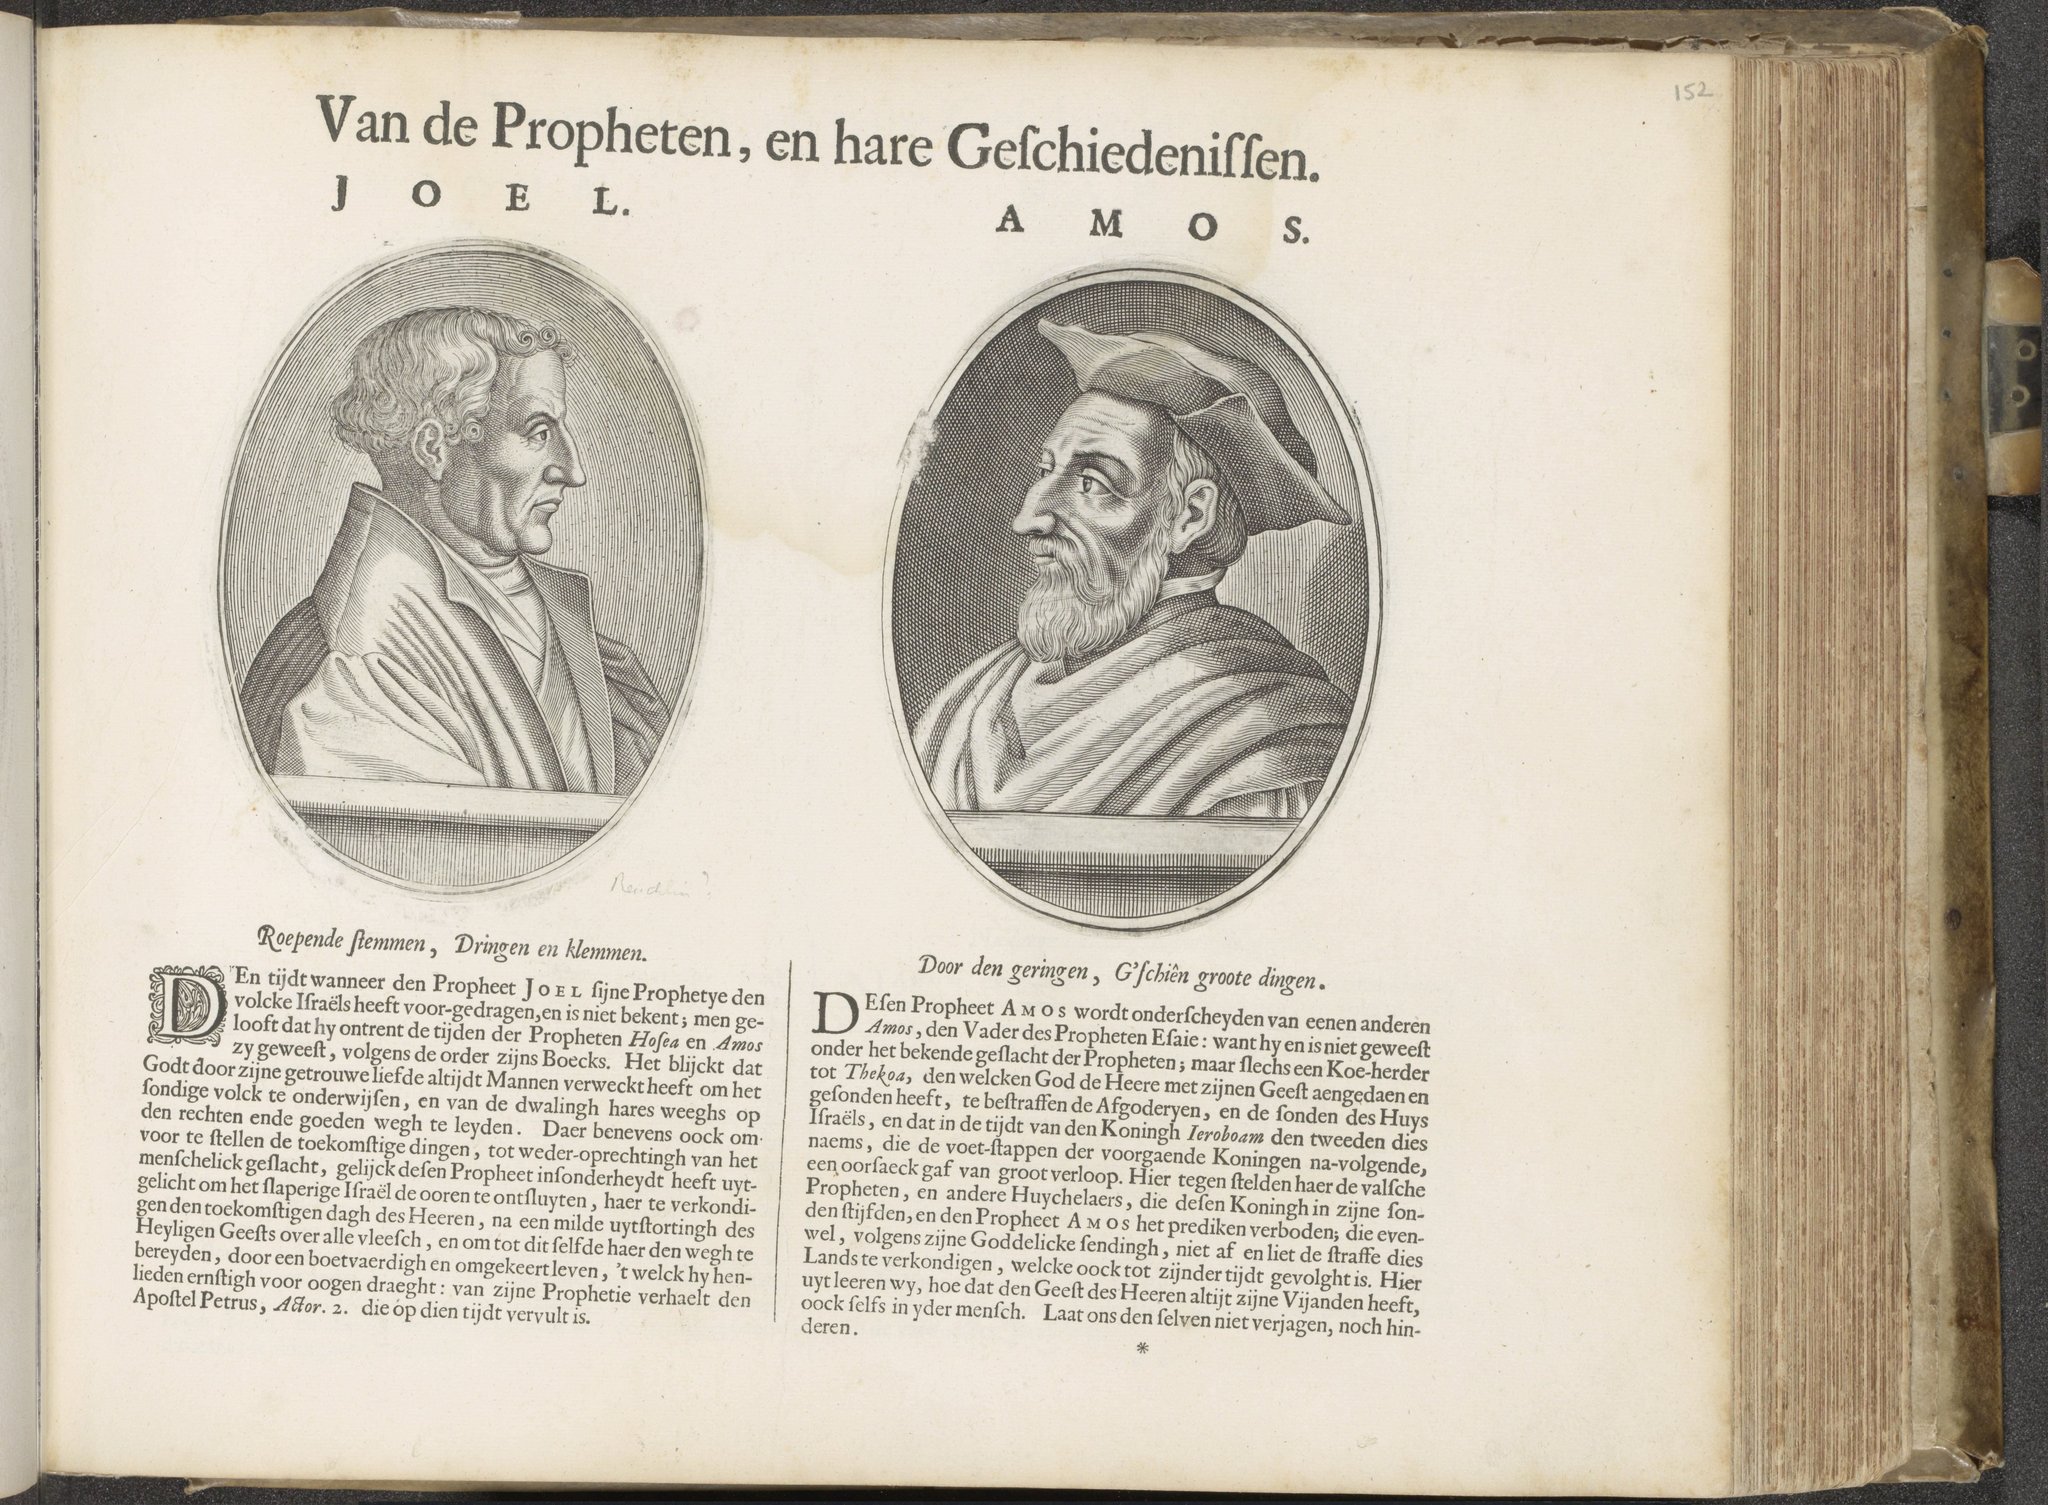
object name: text sheet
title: Den Grooten Emblemata Sacra, bestaande in meer dan vier hondert bybelsche figuren, zoo des Ouden als des Nieuwen Testaments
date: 1610-1625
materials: paper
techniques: engraving, letterpress printing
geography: amsterdam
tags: legeraanvoerder, antonio de leyva, schlettstadt, cambridge, professor, martin bucer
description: Portretten van Martinus Bucer en Antonio de Leyva, in dit album gebruikt als afbeeldingen van respectievelijk de profeten Joël en Amos. De begeleidende tekst begint met een kleine gedecoreerde initiaal D. Het blad maakt deel uit van een album.